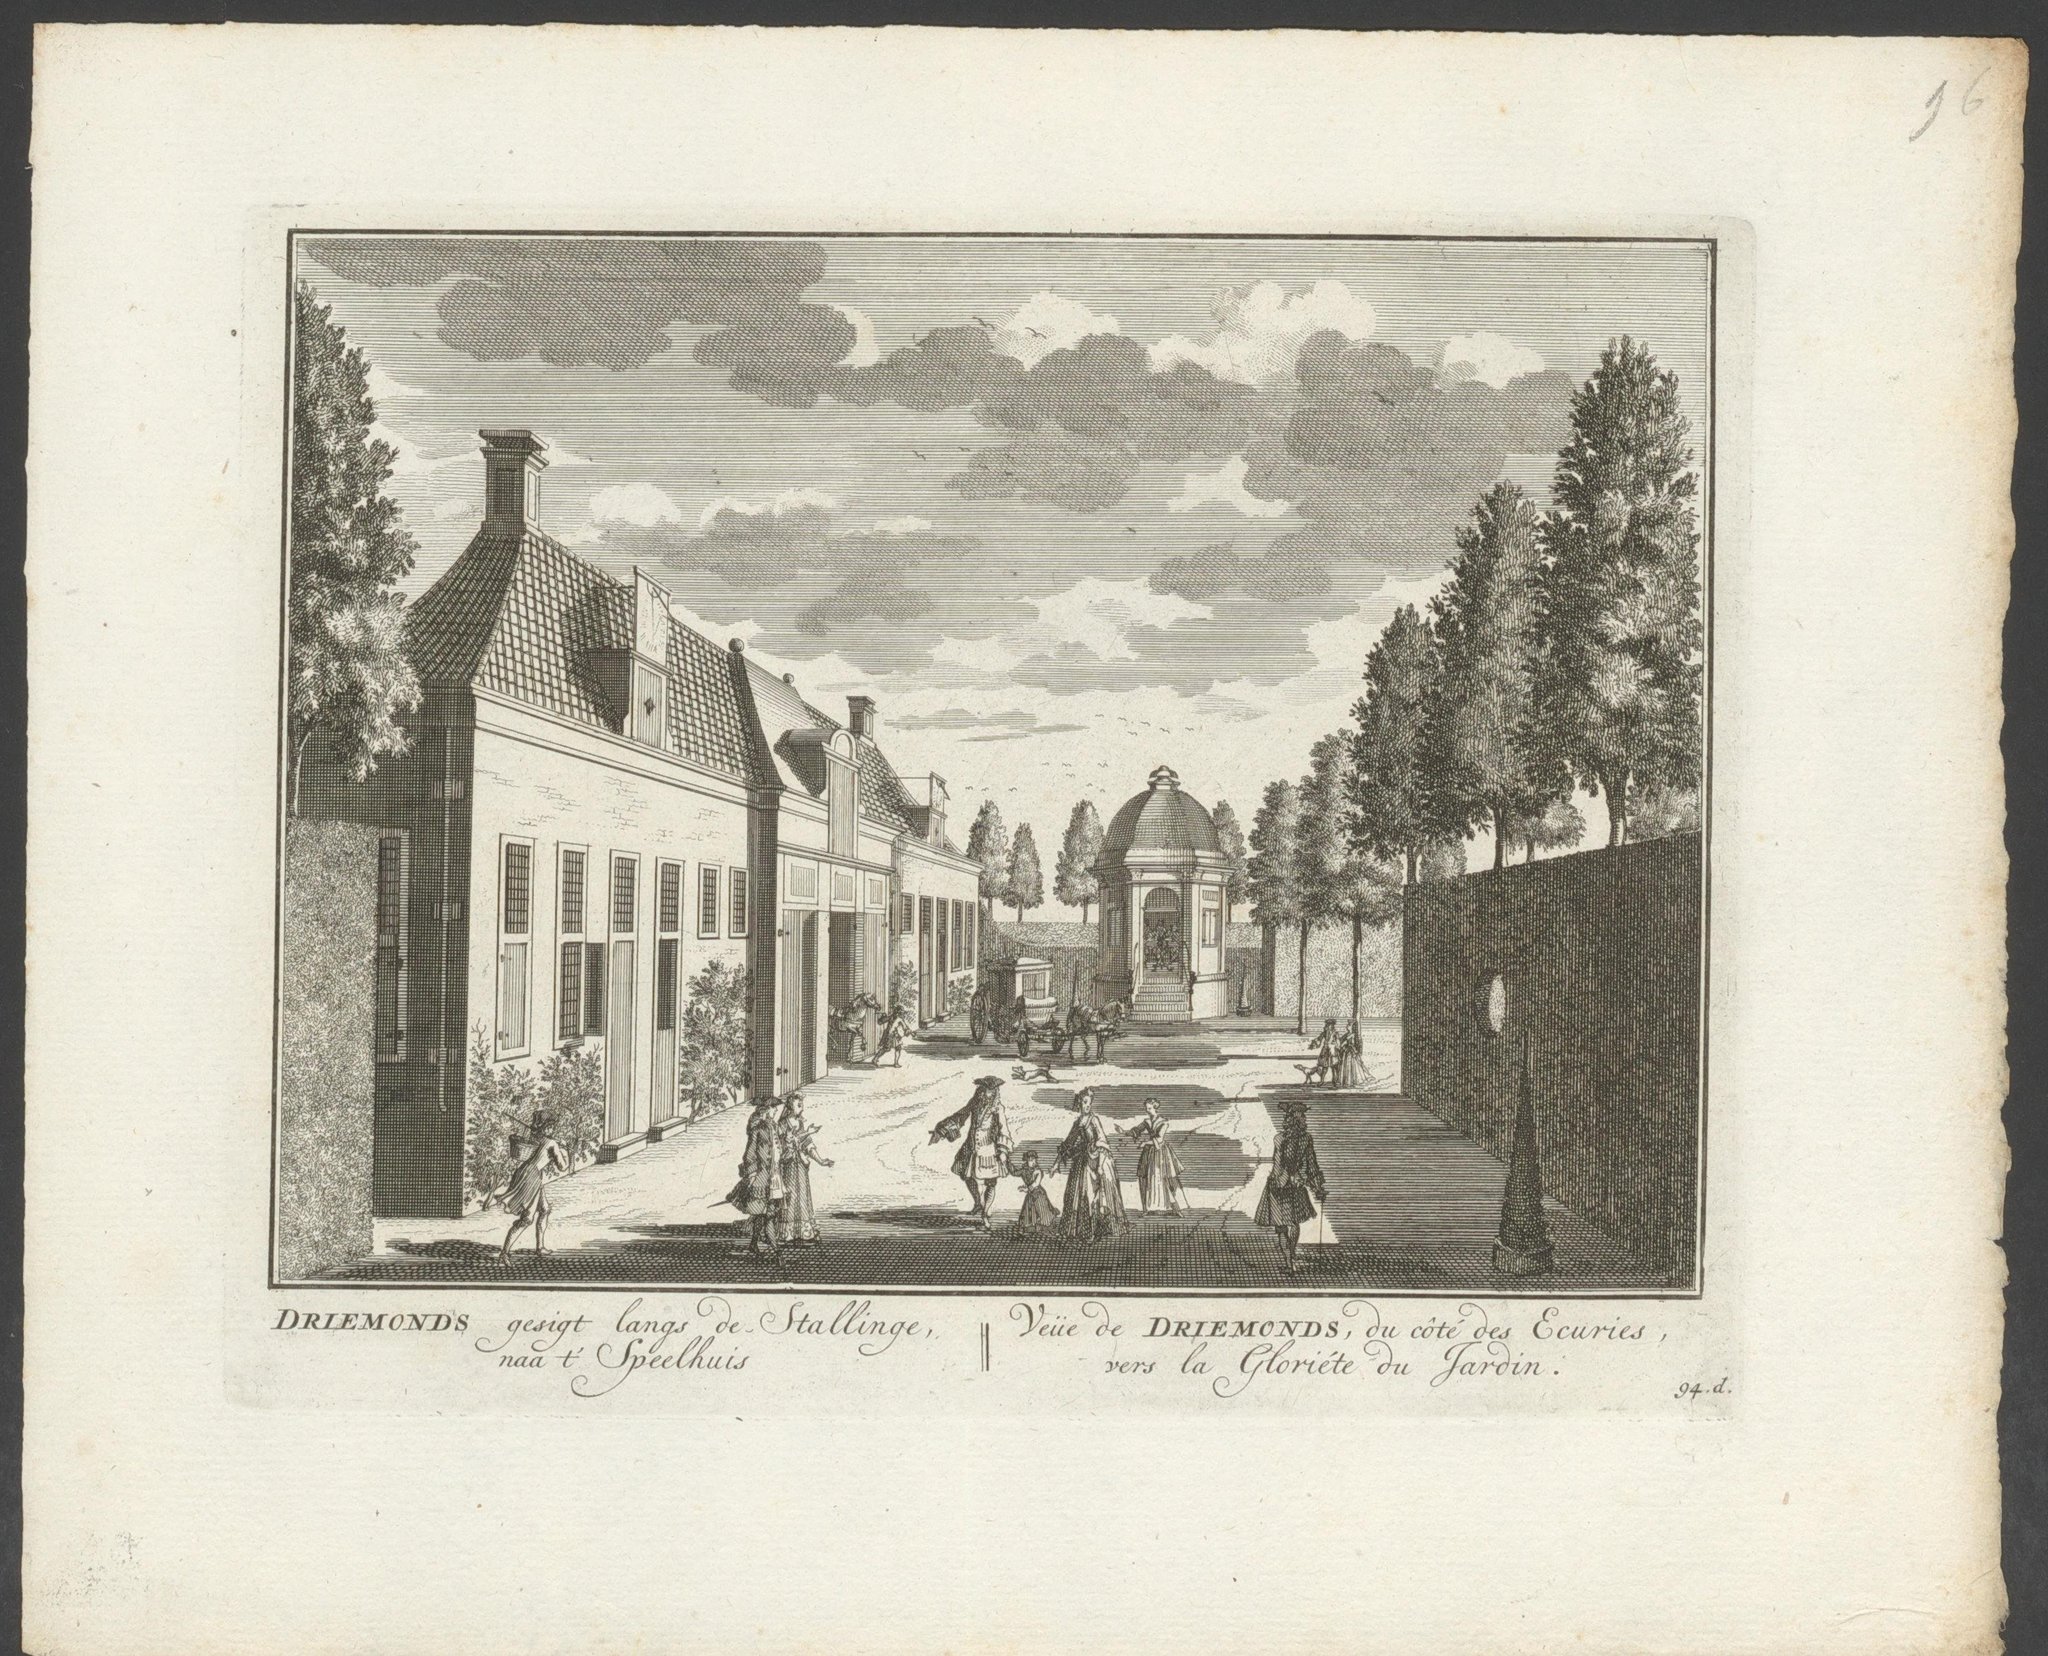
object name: print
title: Gezicht op de stallen en het speelhuis van de buitenplaats Driemond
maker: daniël stopendaal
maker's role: print maker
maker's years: 1672-1726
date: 1790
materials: paper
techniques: engraving, etching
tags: garden, stall, stable, amsterdam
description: Prent mogelijk uit: Leth, Andries de. De zegepraalende Vecht, vertoonende verscheidene gesichten van lustplaatsen, heeren huysen en dorpen, beginnende van Uitrecht en met Muyden besluytende (...). Amsterdam: Weduwe Nicolaus Visscher, 1719. Prent of uit: Brouërius van Nidek, Matthaeus. De Vechtstroom, van Utrecht tot Muiden (...). Amsterdam: H. Gartman, W. Vermandel en J.W. Smit, 1790.